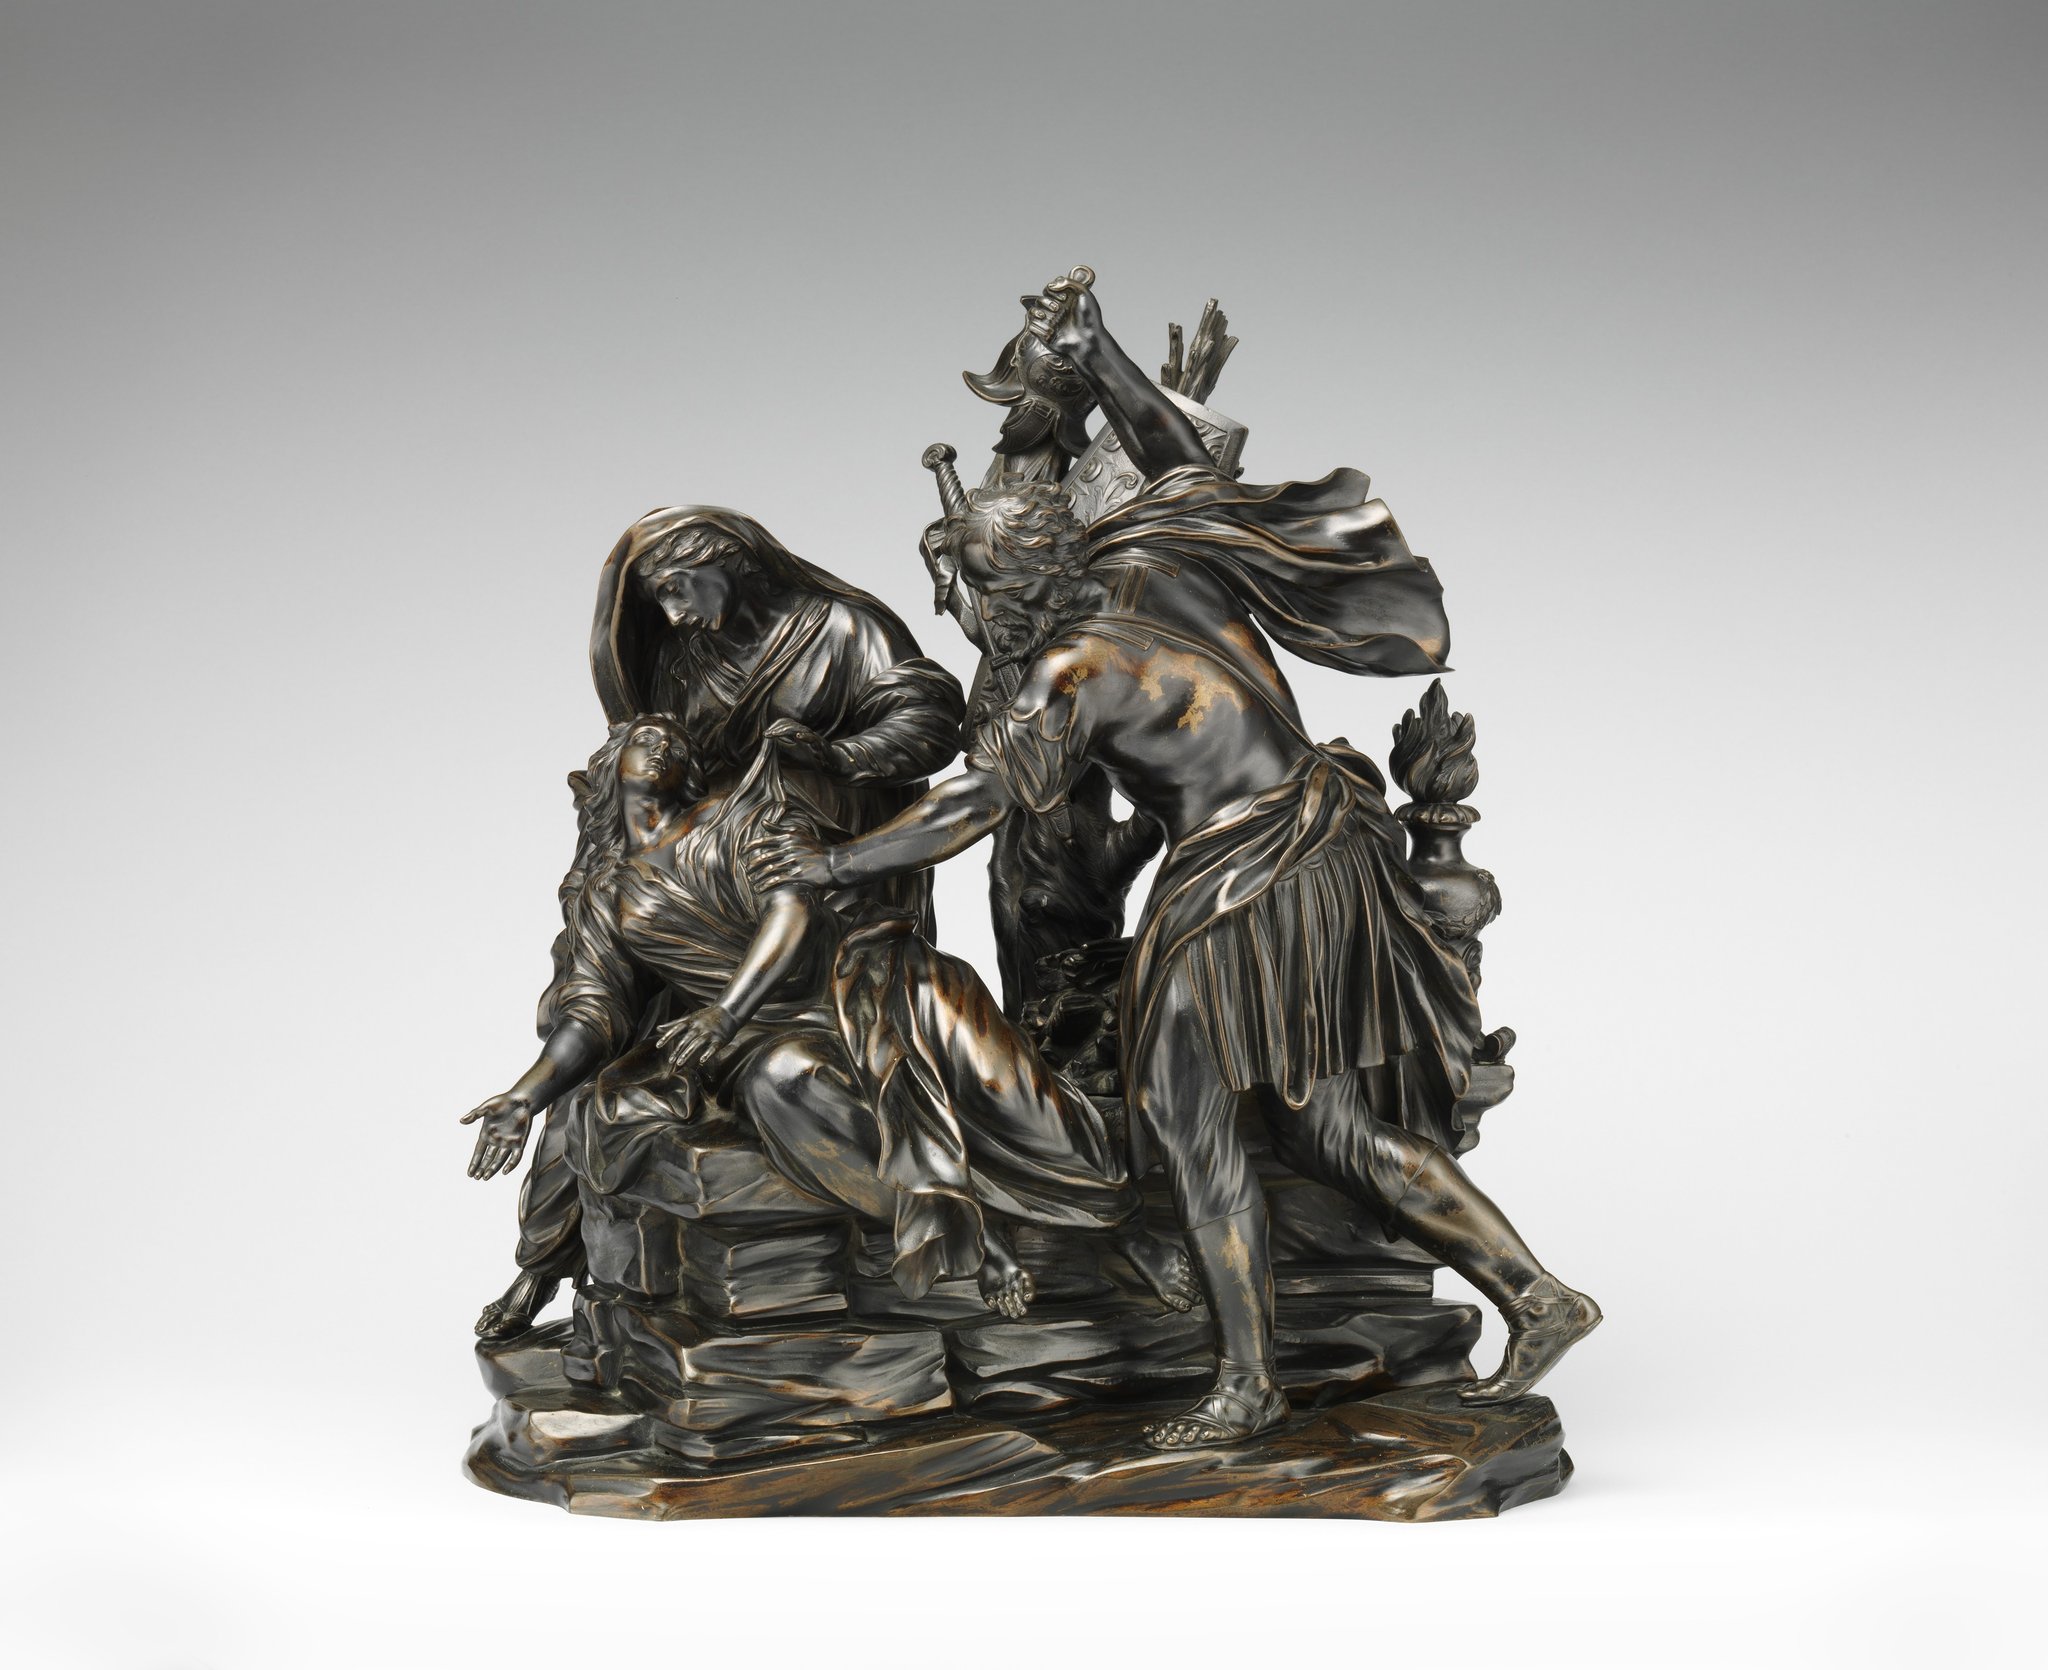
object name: statuette group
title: The Sacrifice of Jephthah's Daughter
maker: massimiliano soldani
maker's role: artist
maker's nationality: italian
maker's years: 1656-1740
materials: bronze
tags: girls,men,women